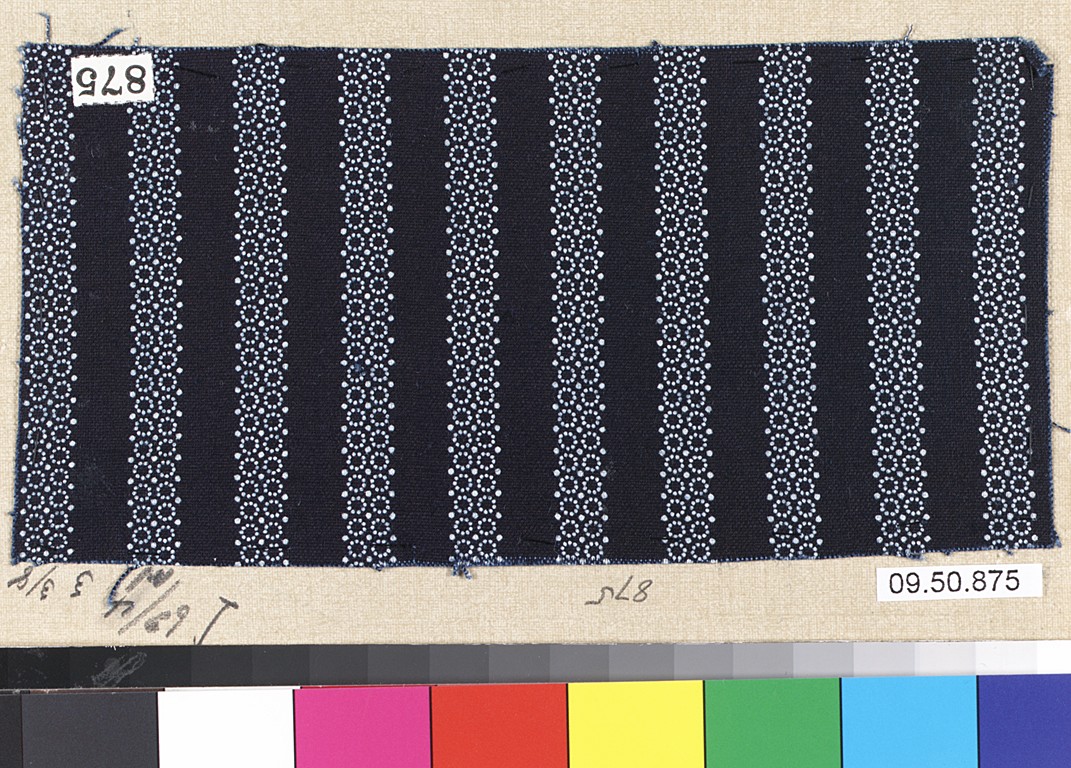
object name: piece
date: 1801-1900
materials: cotton